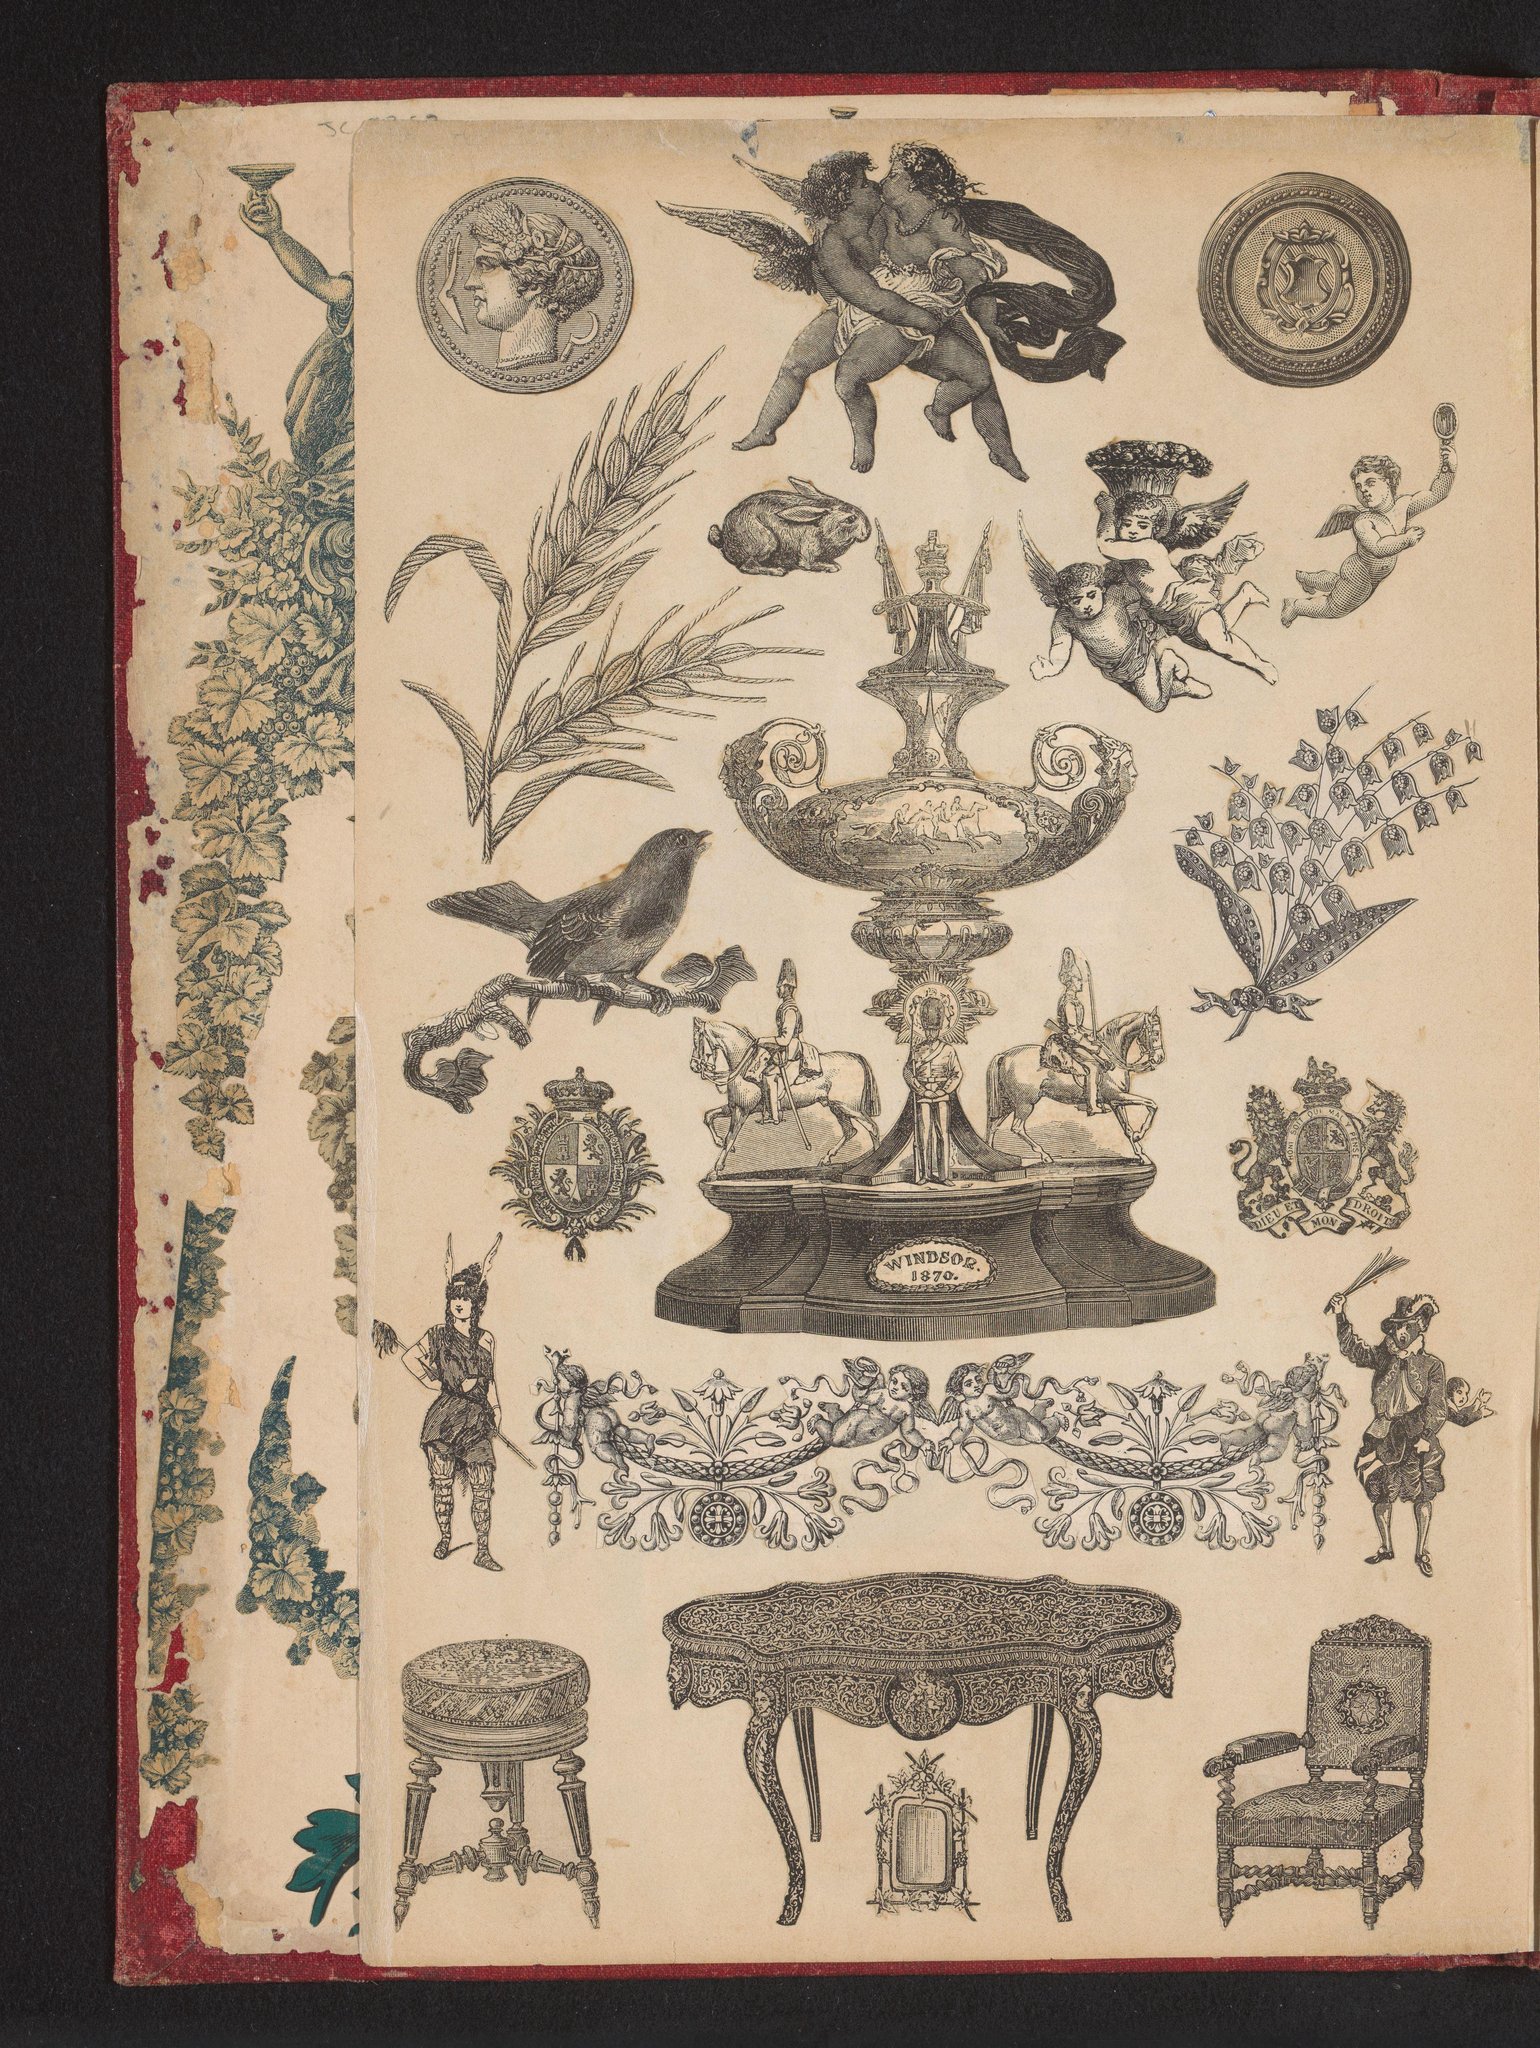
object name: collage visual work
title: Collage van uitgeknipte prenten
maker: Anonymous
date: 1870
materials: paper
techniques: engraving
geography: paris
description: Collage van uitgeknipte prenten. Onderdeel van een album met 18 bladen, aan beide zijden beplakt met uitgeknipte prenten, vermoedelijk afkomstig uit 19e-eeuwse tijdschiften.